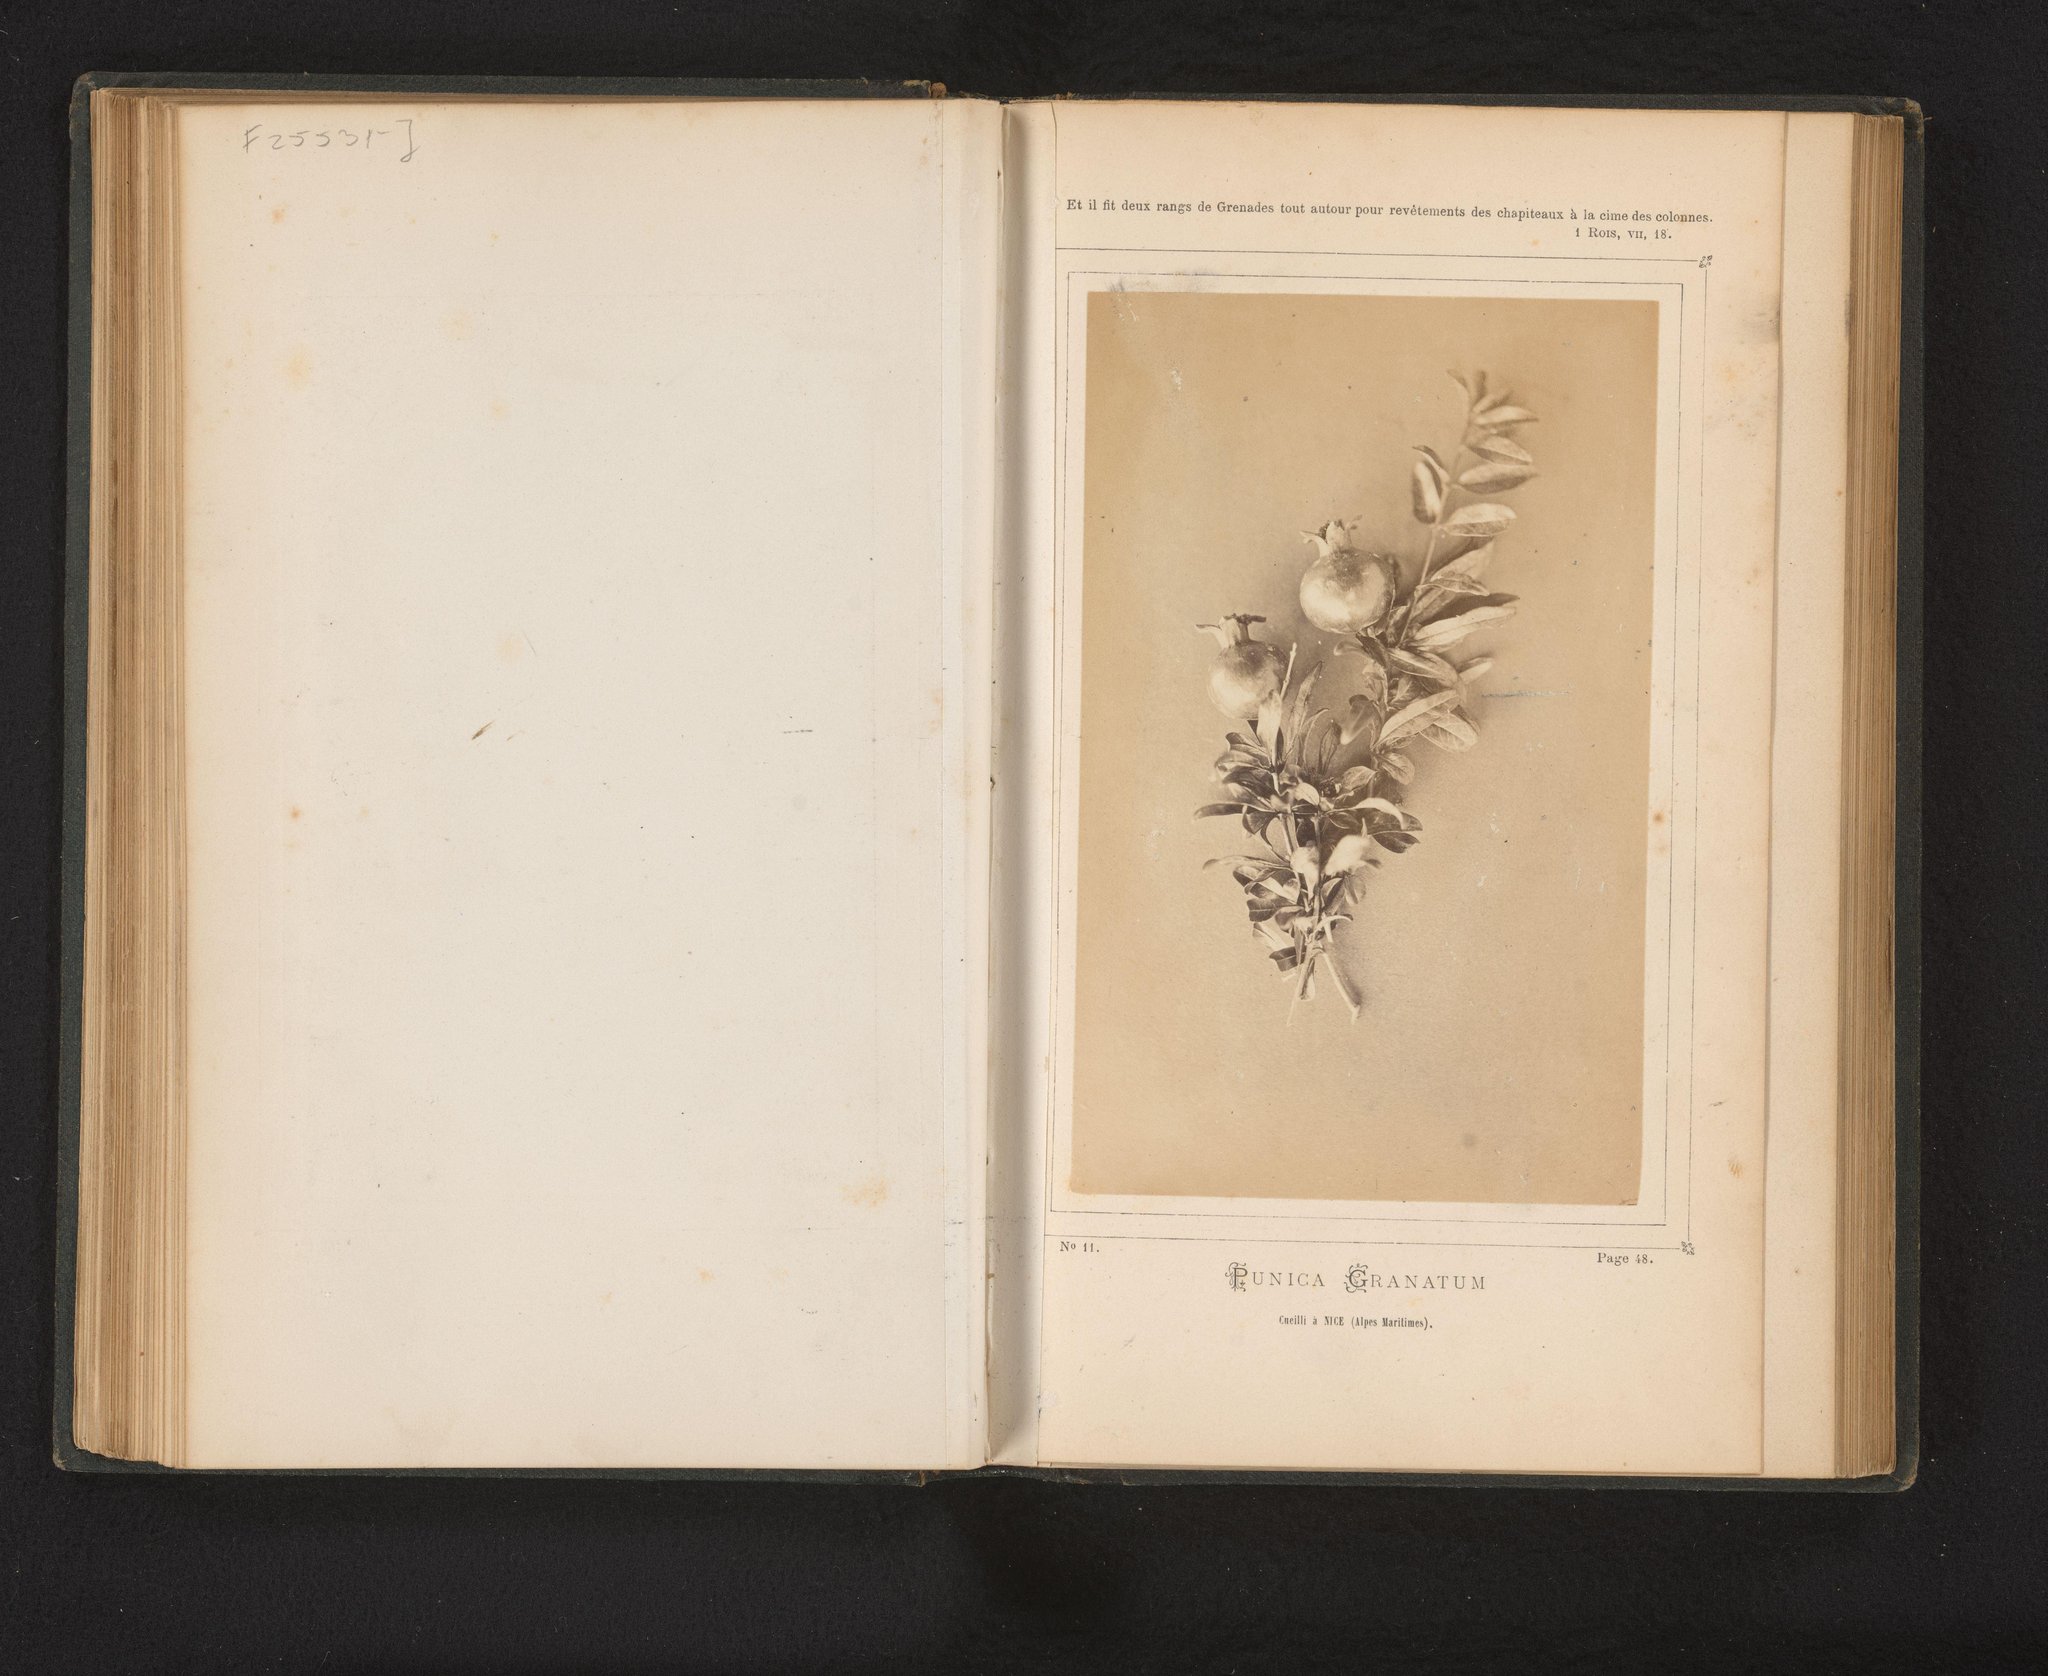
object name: photograph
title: Punica Granatum. Cueilli à Nice. Alpes Maritimes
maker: jean walburg de bray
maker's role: fotograaf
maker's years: 1839-1901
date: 1866-1871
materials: paper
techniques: albumen print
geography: nice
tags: trees: pomegranate-tree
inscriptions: inscription: ‘Et il fit deux rangs de Grenades tout antour pour revêtements des chapiteaux à la cime des colonnes./ 1 ROIS, VII, 18.’, number: ‘No 11.’, inscription: ‘Page 48.’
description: Foto op derde ongenummerde pagina na pagina 48.